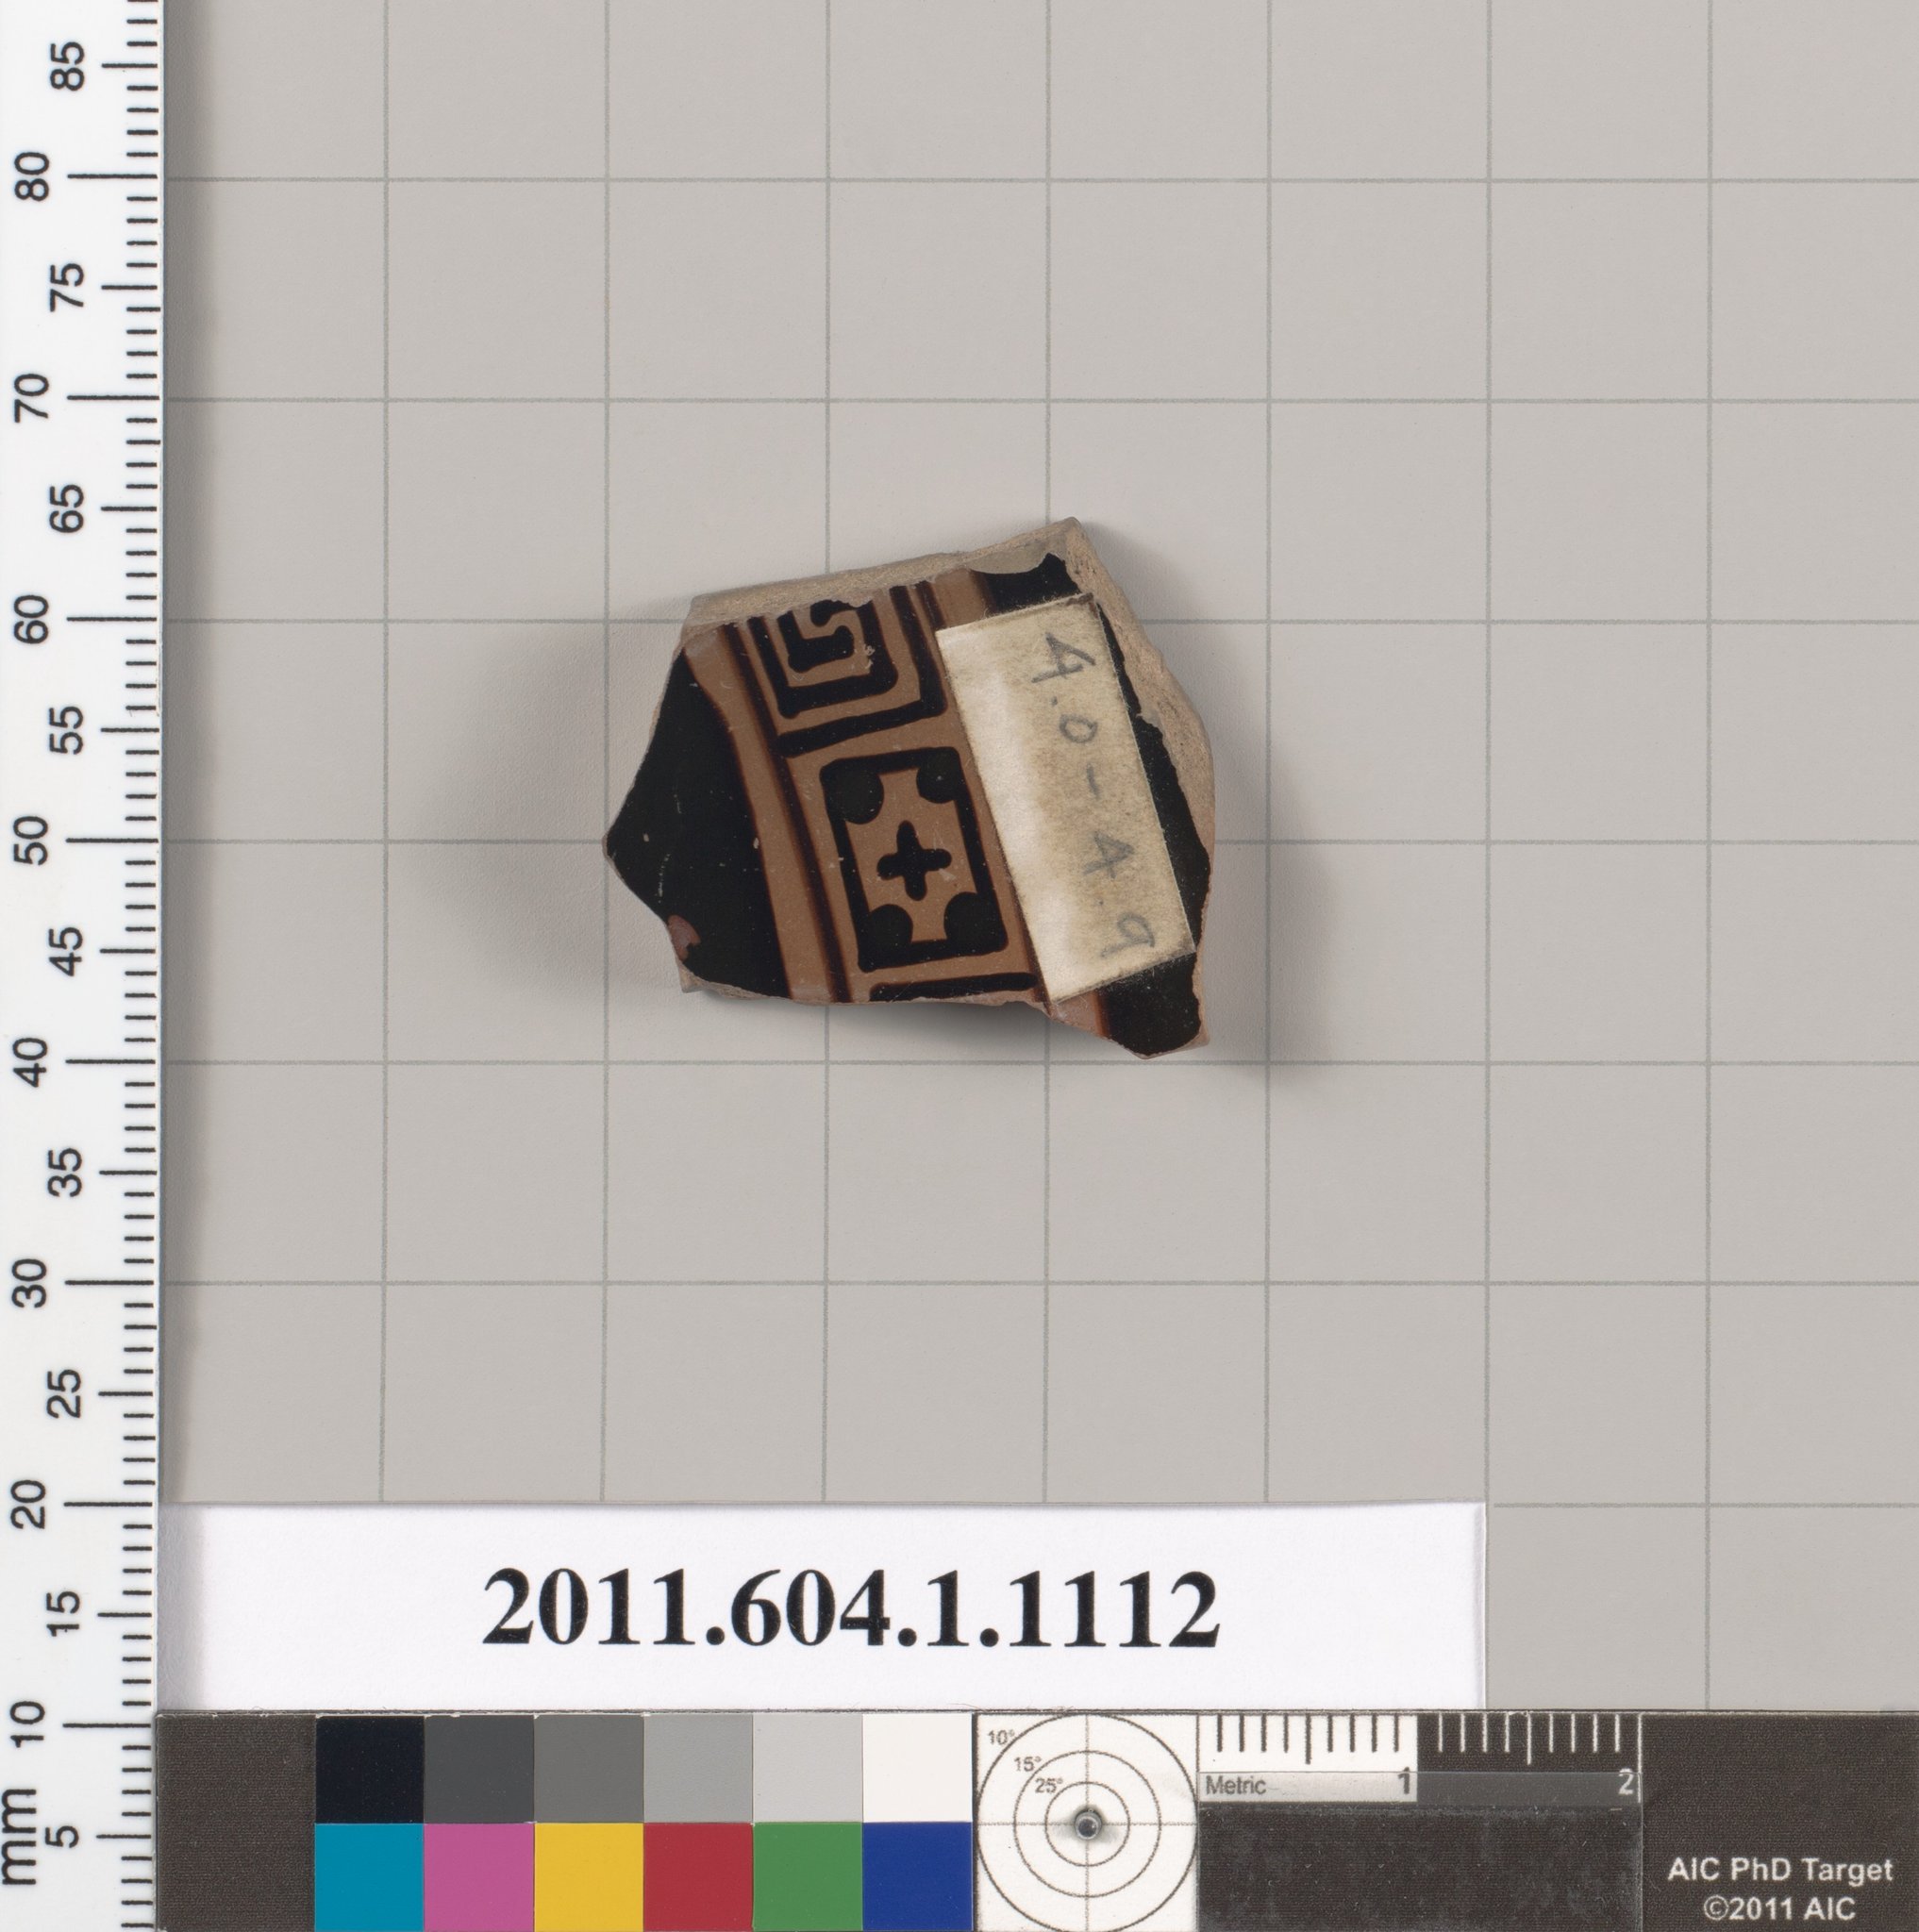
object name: kylix fragment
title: Terracotta fragment of a kylix (drinking cup)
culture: greek, attic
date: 490-480 BCE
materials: terracotta